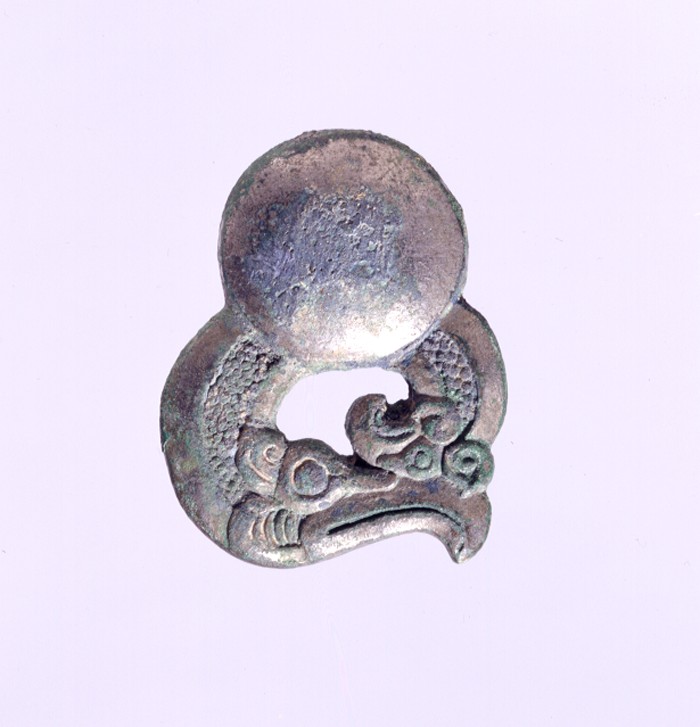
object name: harness ornament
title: Harness Ornament with Bird's-Head Terminals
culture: northwest chinese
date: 400-301 BCE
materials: bronze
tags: birds